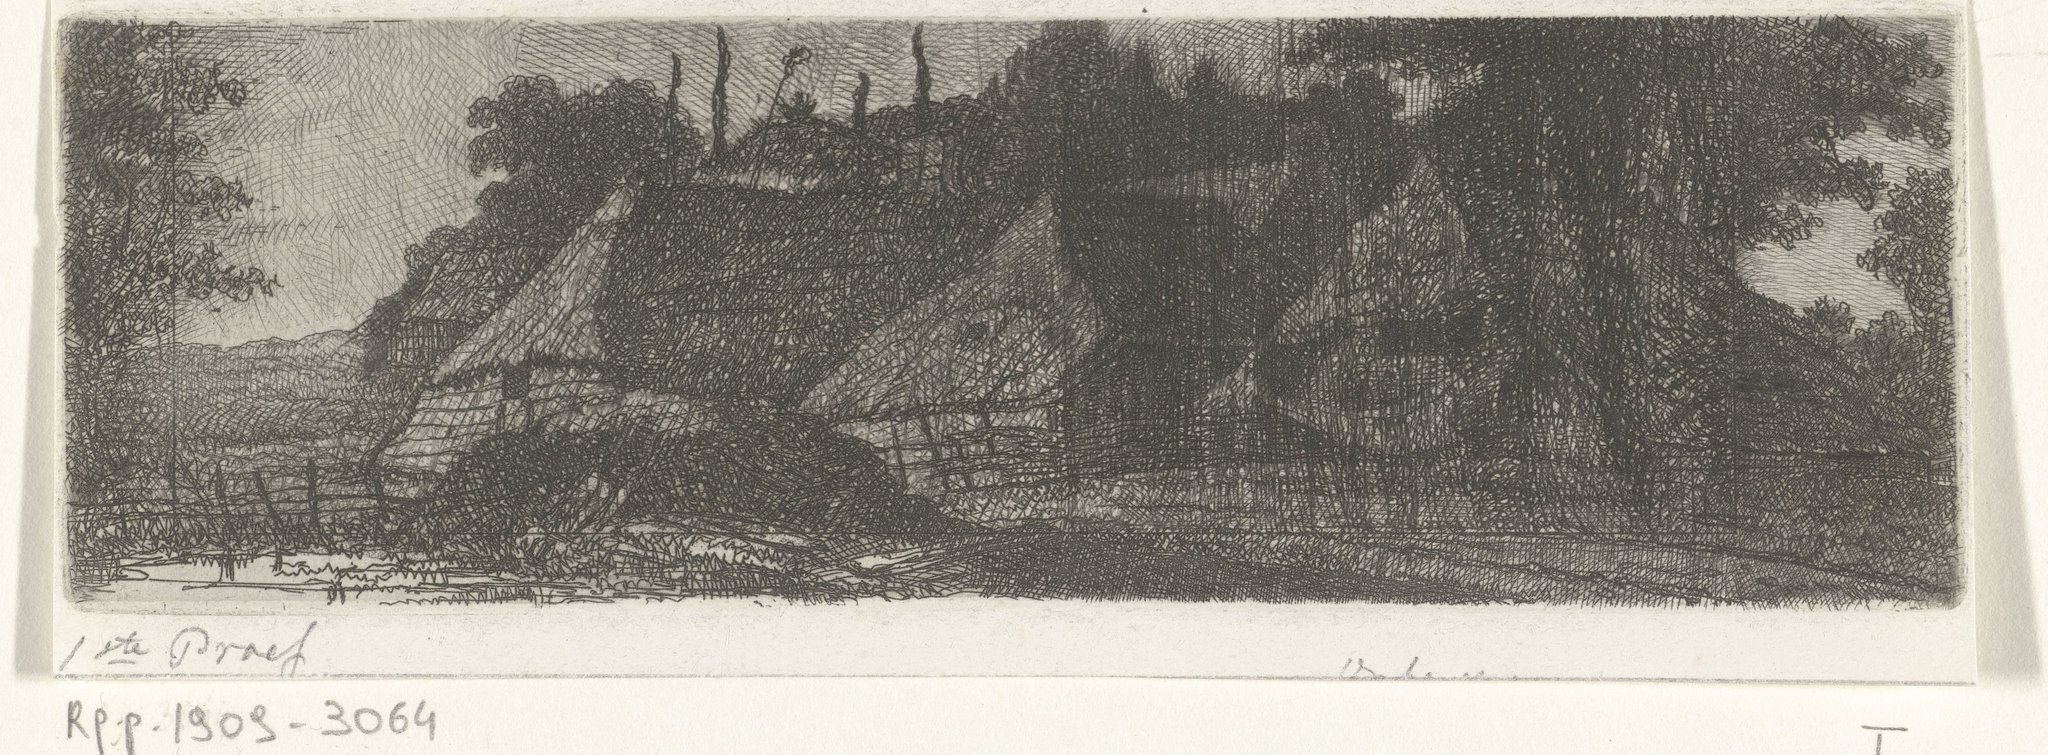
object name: print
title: Landschap met drie boerderijen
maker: jacobus ludovicus cornet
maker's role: draughtsman, print maker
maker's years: 1815-1882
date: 1825-1882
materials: paper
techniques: etching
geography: leiden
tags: farm (building)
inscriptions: collector's mark: Lugt 2228